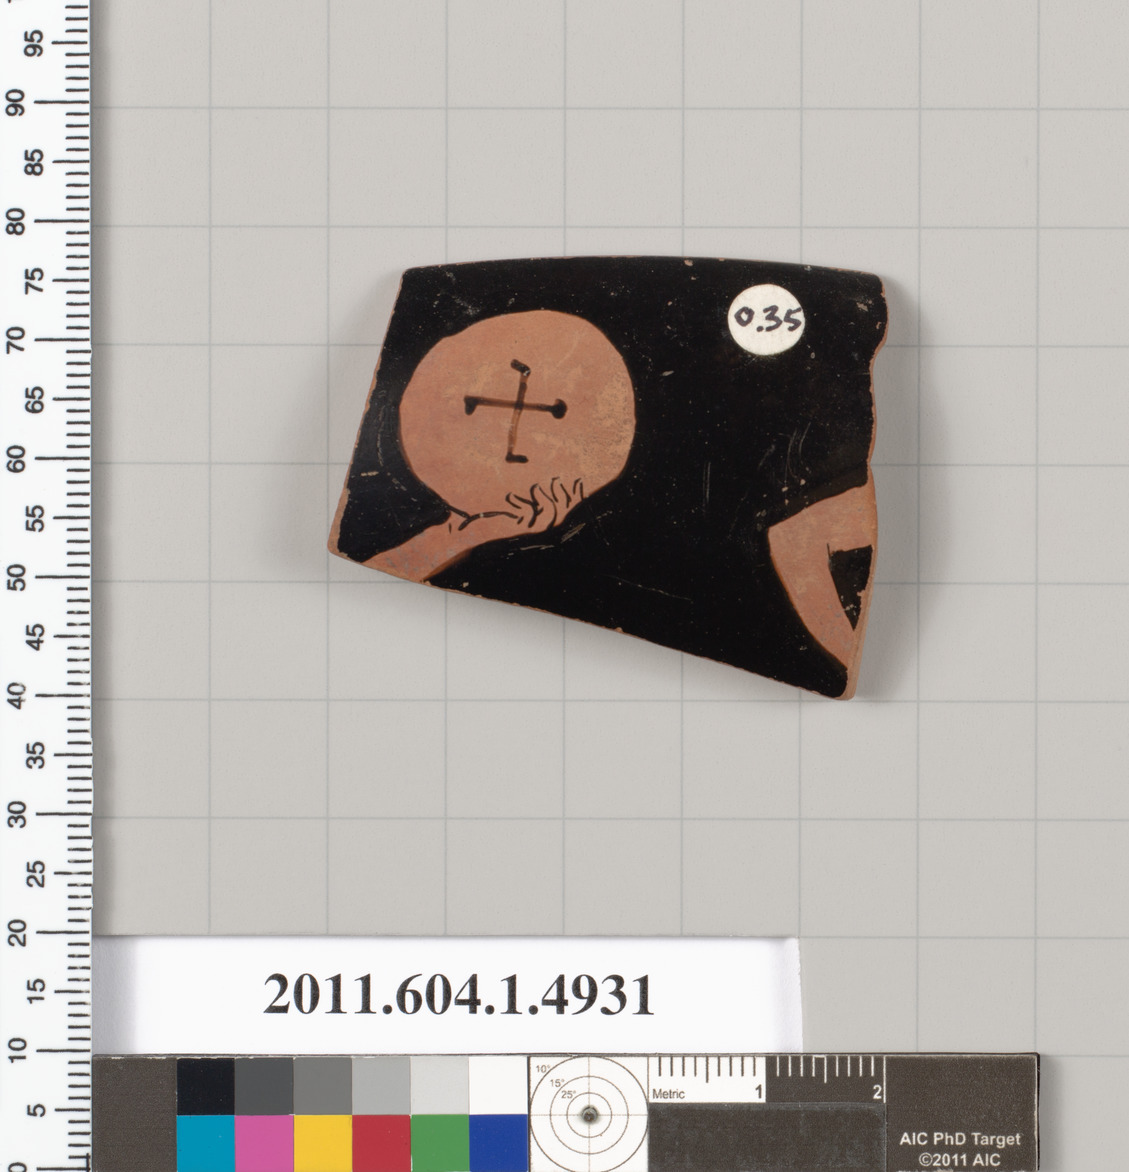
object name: kylix fragment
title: Terracotta rim fragment of a kylix (drinking cup)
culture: greek, attic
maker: akestorides painter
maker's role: artist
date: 475-451 BCE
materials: terracotta